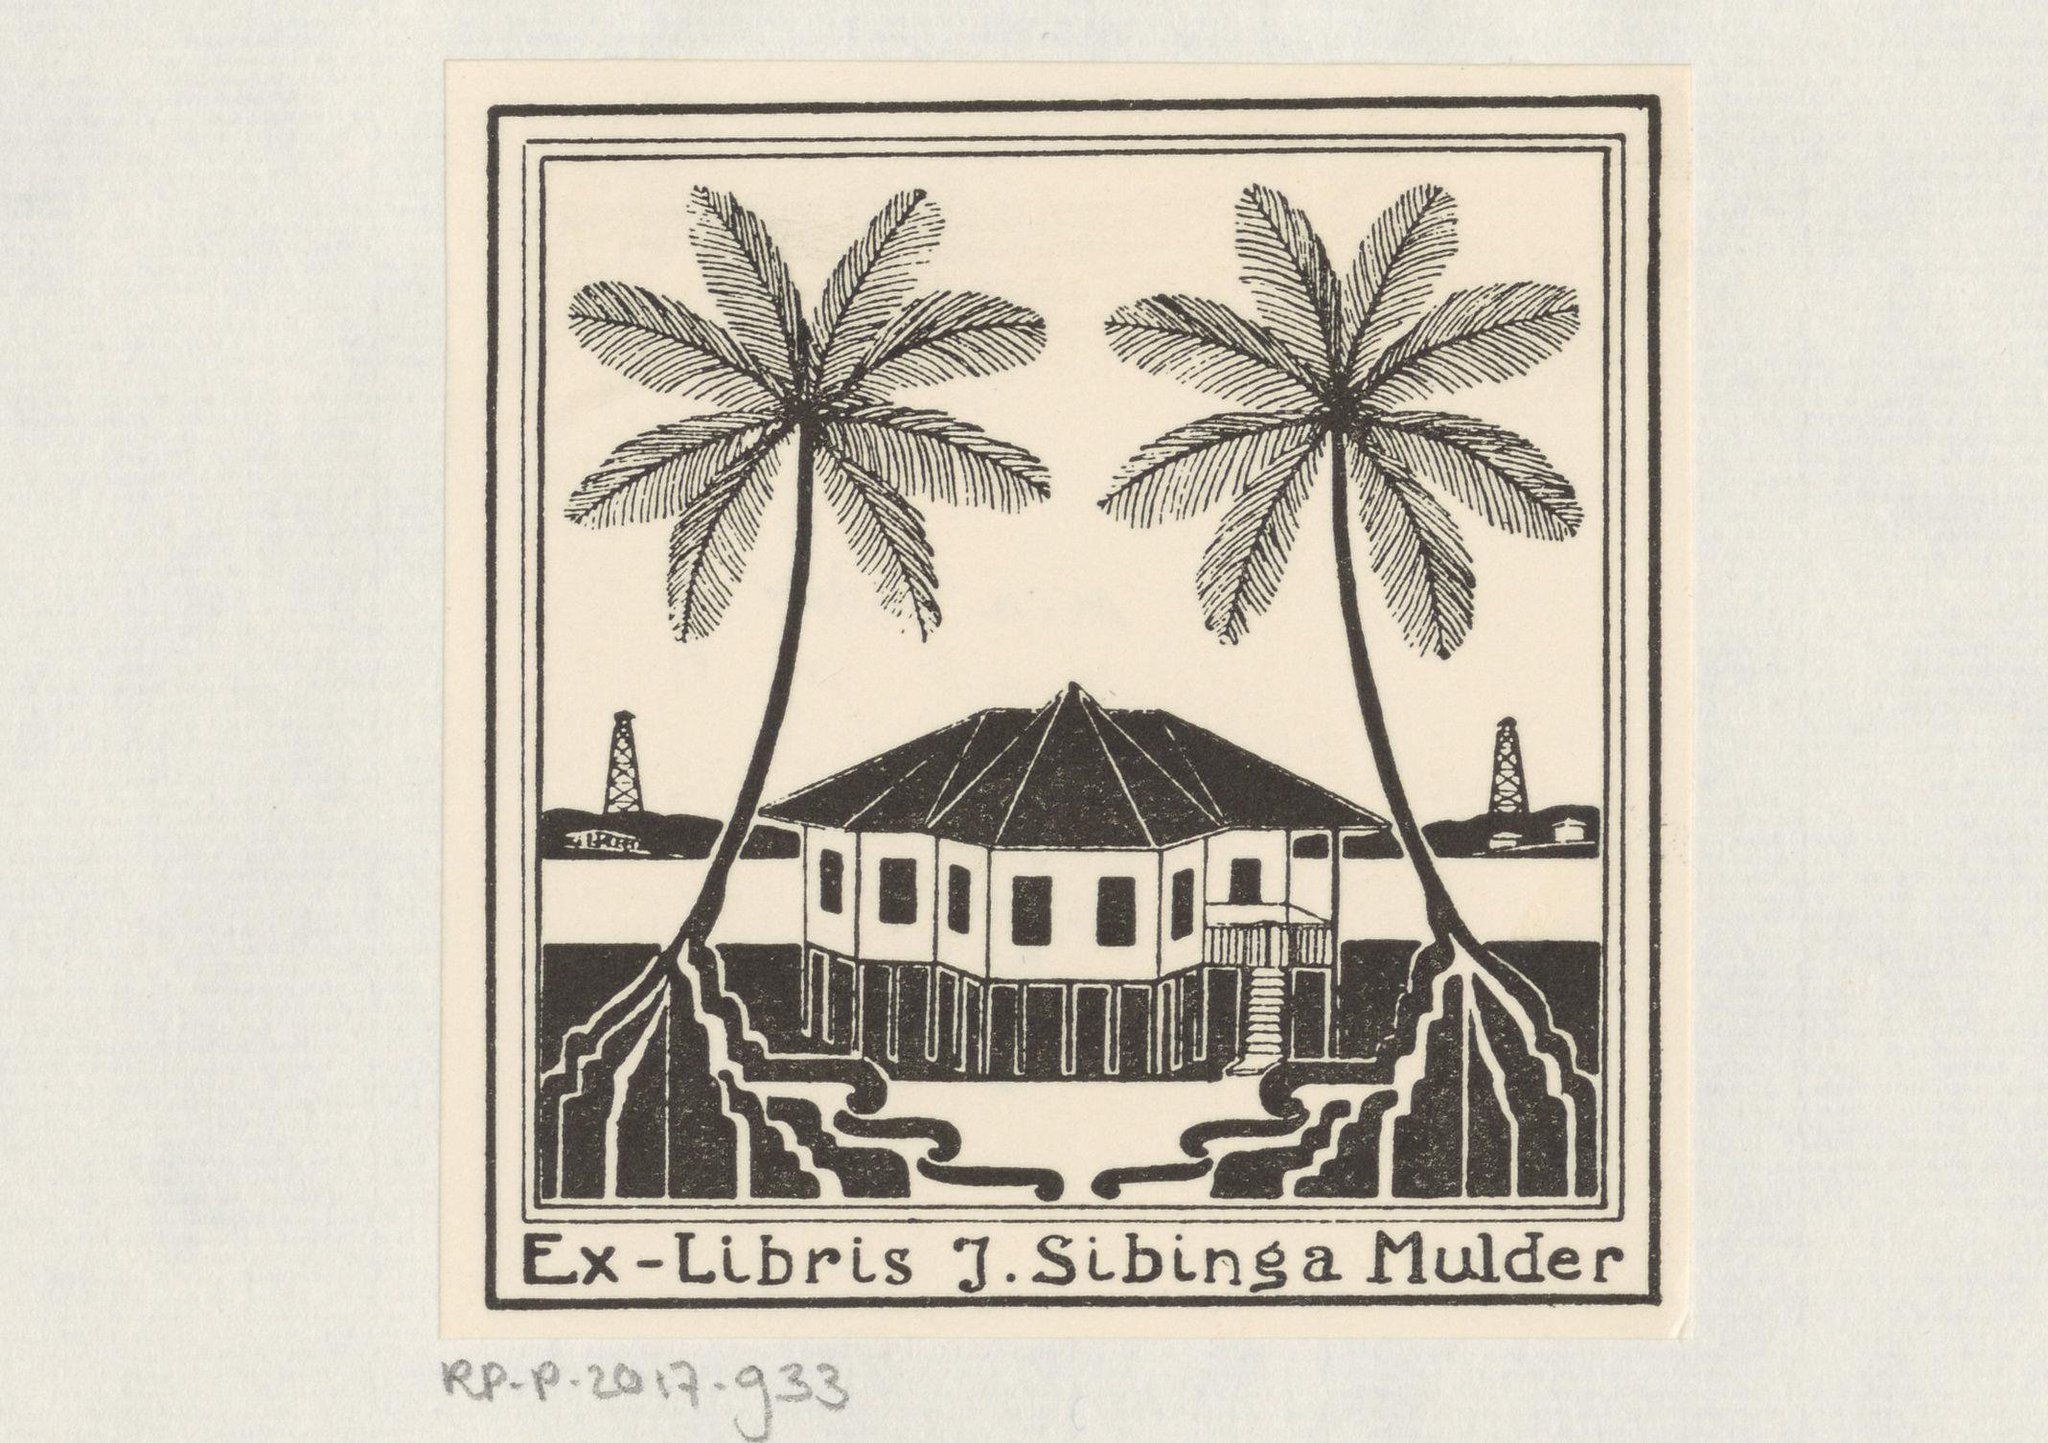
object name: bookplate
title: Ex libris van J. Sibinga Mulder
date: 1876-1944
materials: paper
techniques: printing block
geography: netherlands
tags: amsterdam, politician, johannes sibinga mulder, housing, trees: palm-tree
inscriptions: inscription: ‘i.f’